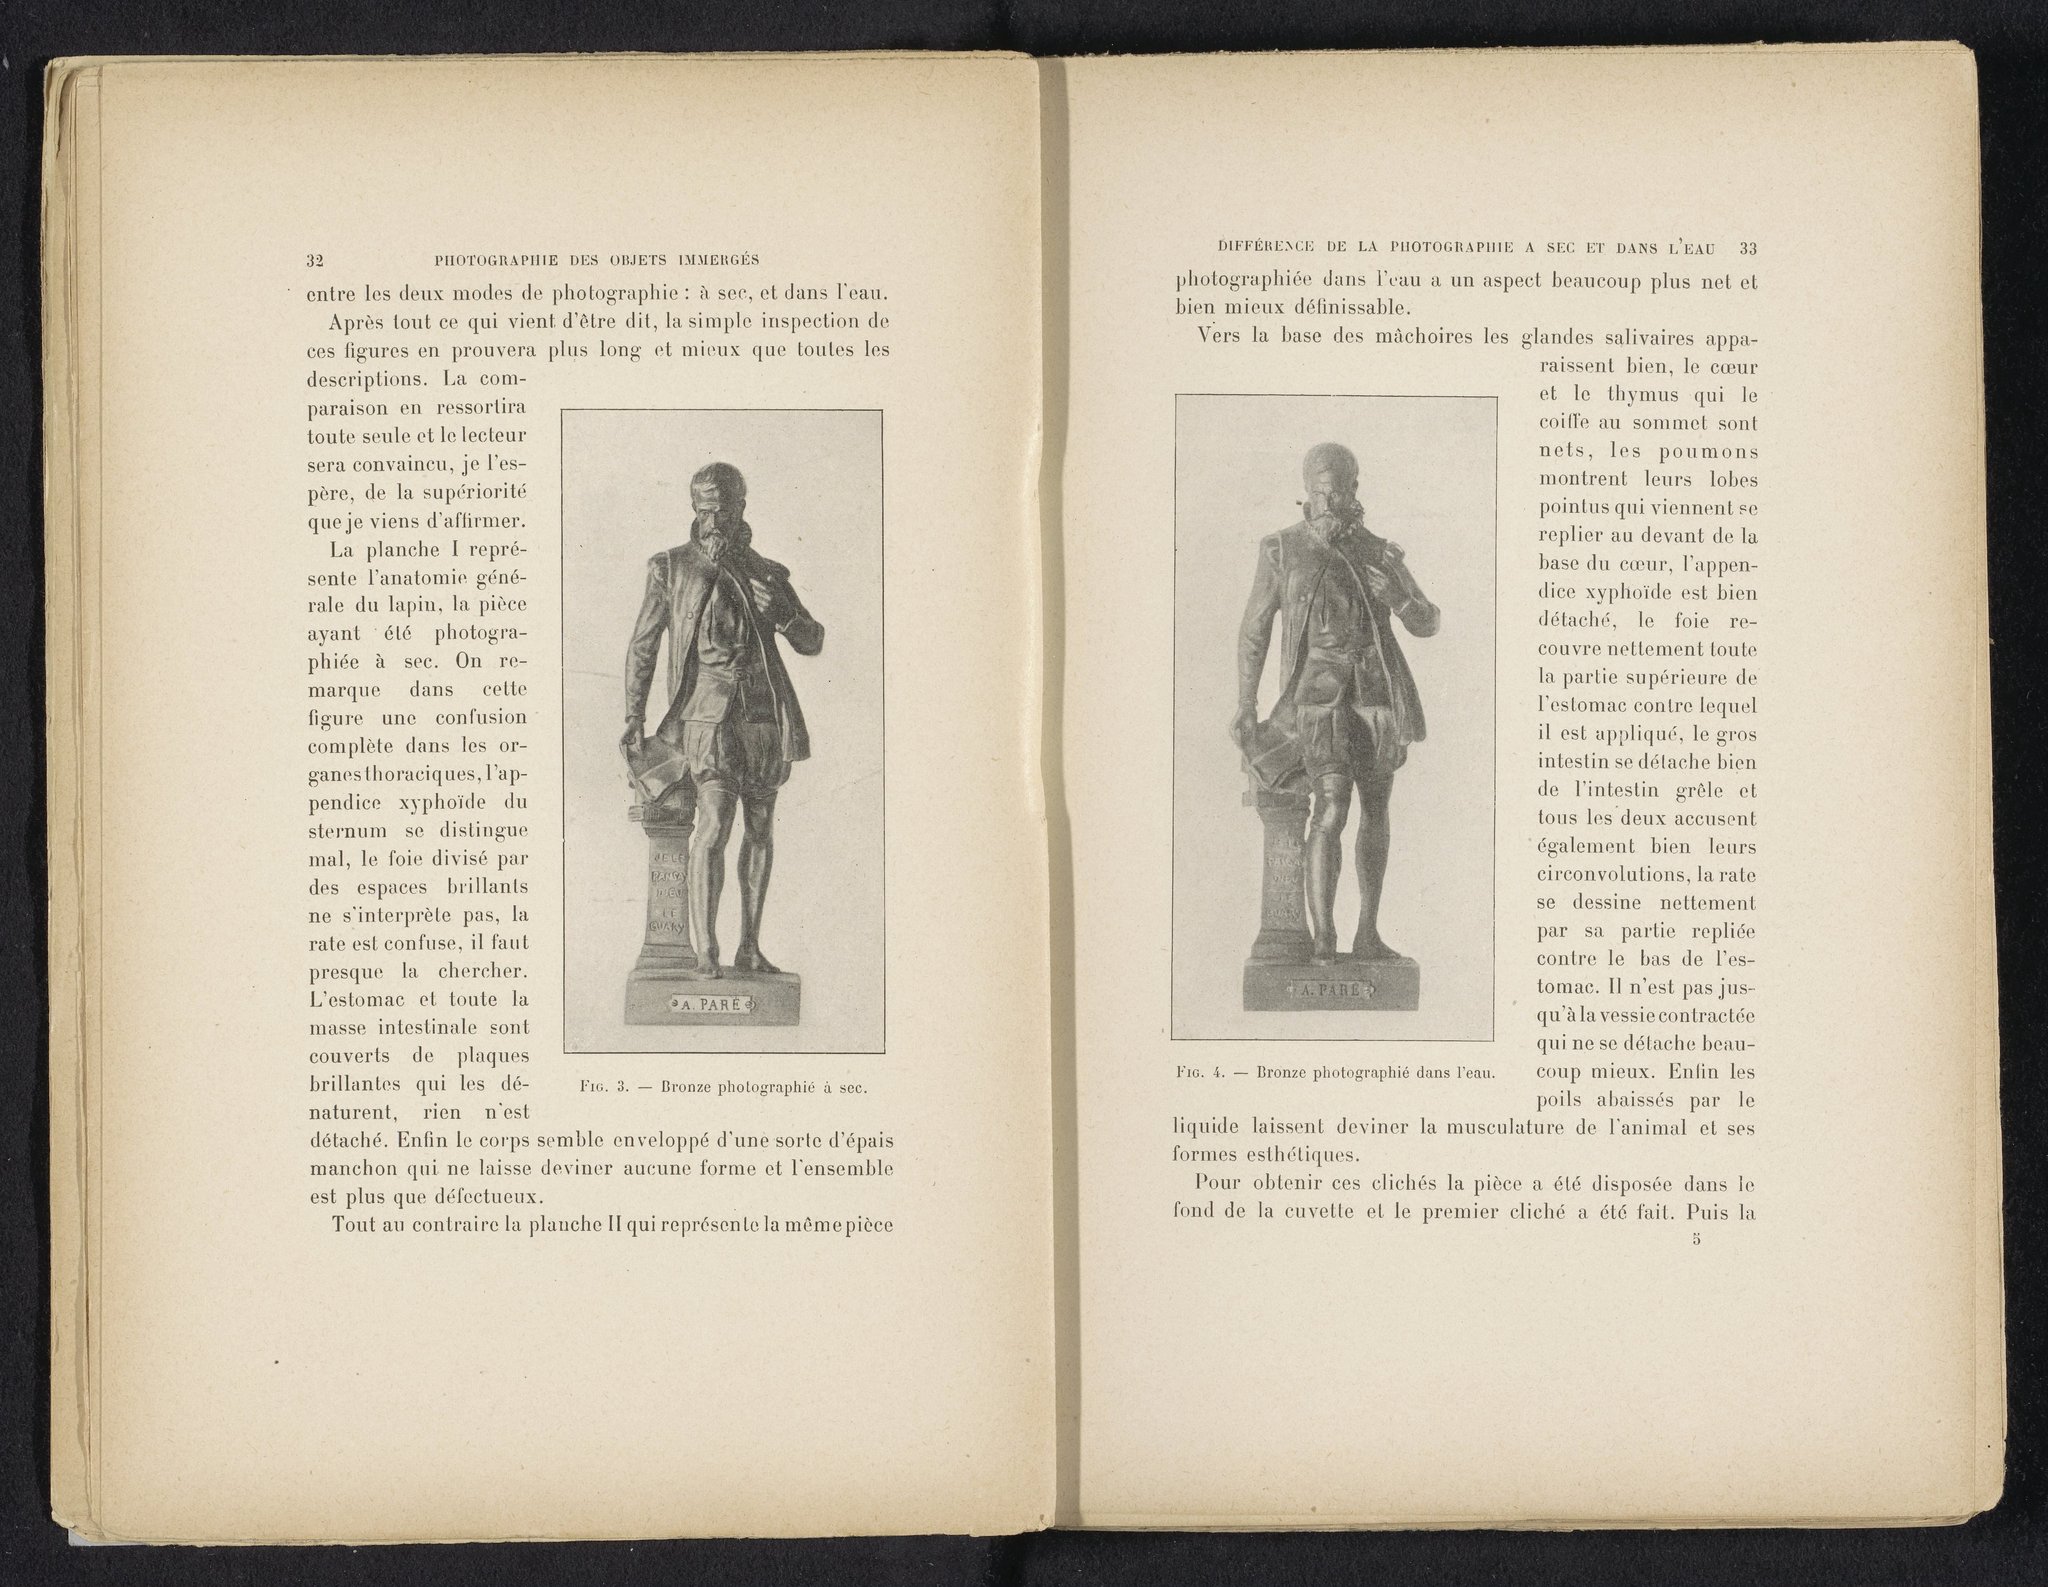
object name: photomechanical print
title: Bronze photographié à sec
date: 1891-1901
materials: paper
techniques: autotype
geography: paris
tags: sculpture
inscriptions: number: ‘Fig. 3.’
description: Prent in album 'La photographie des objets immergés', 1901.